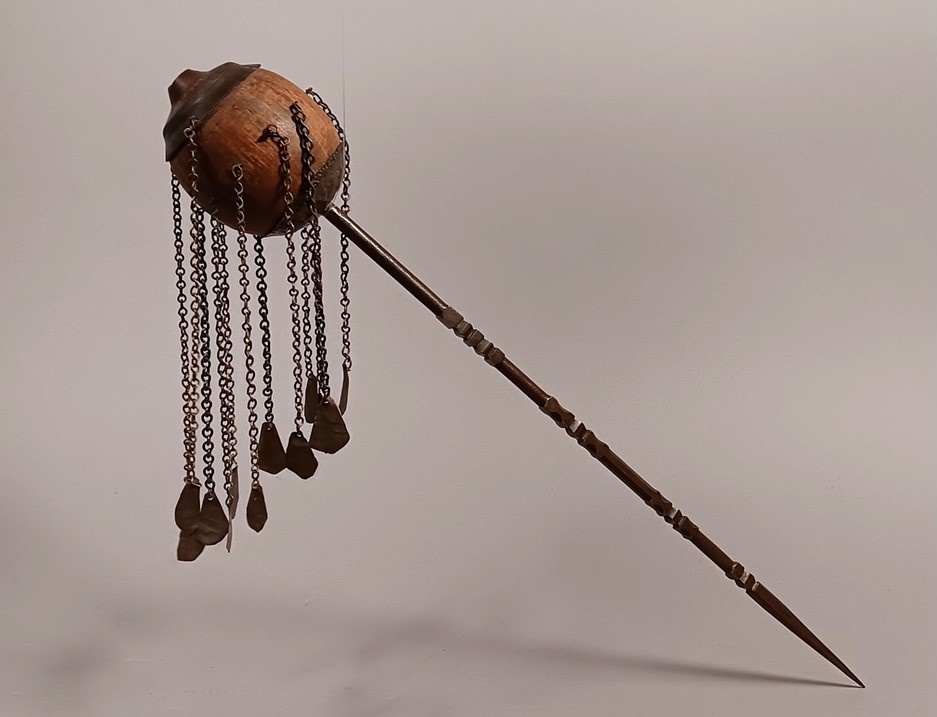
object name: dabbous zarf or darb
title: Dabbous (zarf or darb)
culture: turkish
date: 1867-1900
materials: metal, wood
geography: turkey